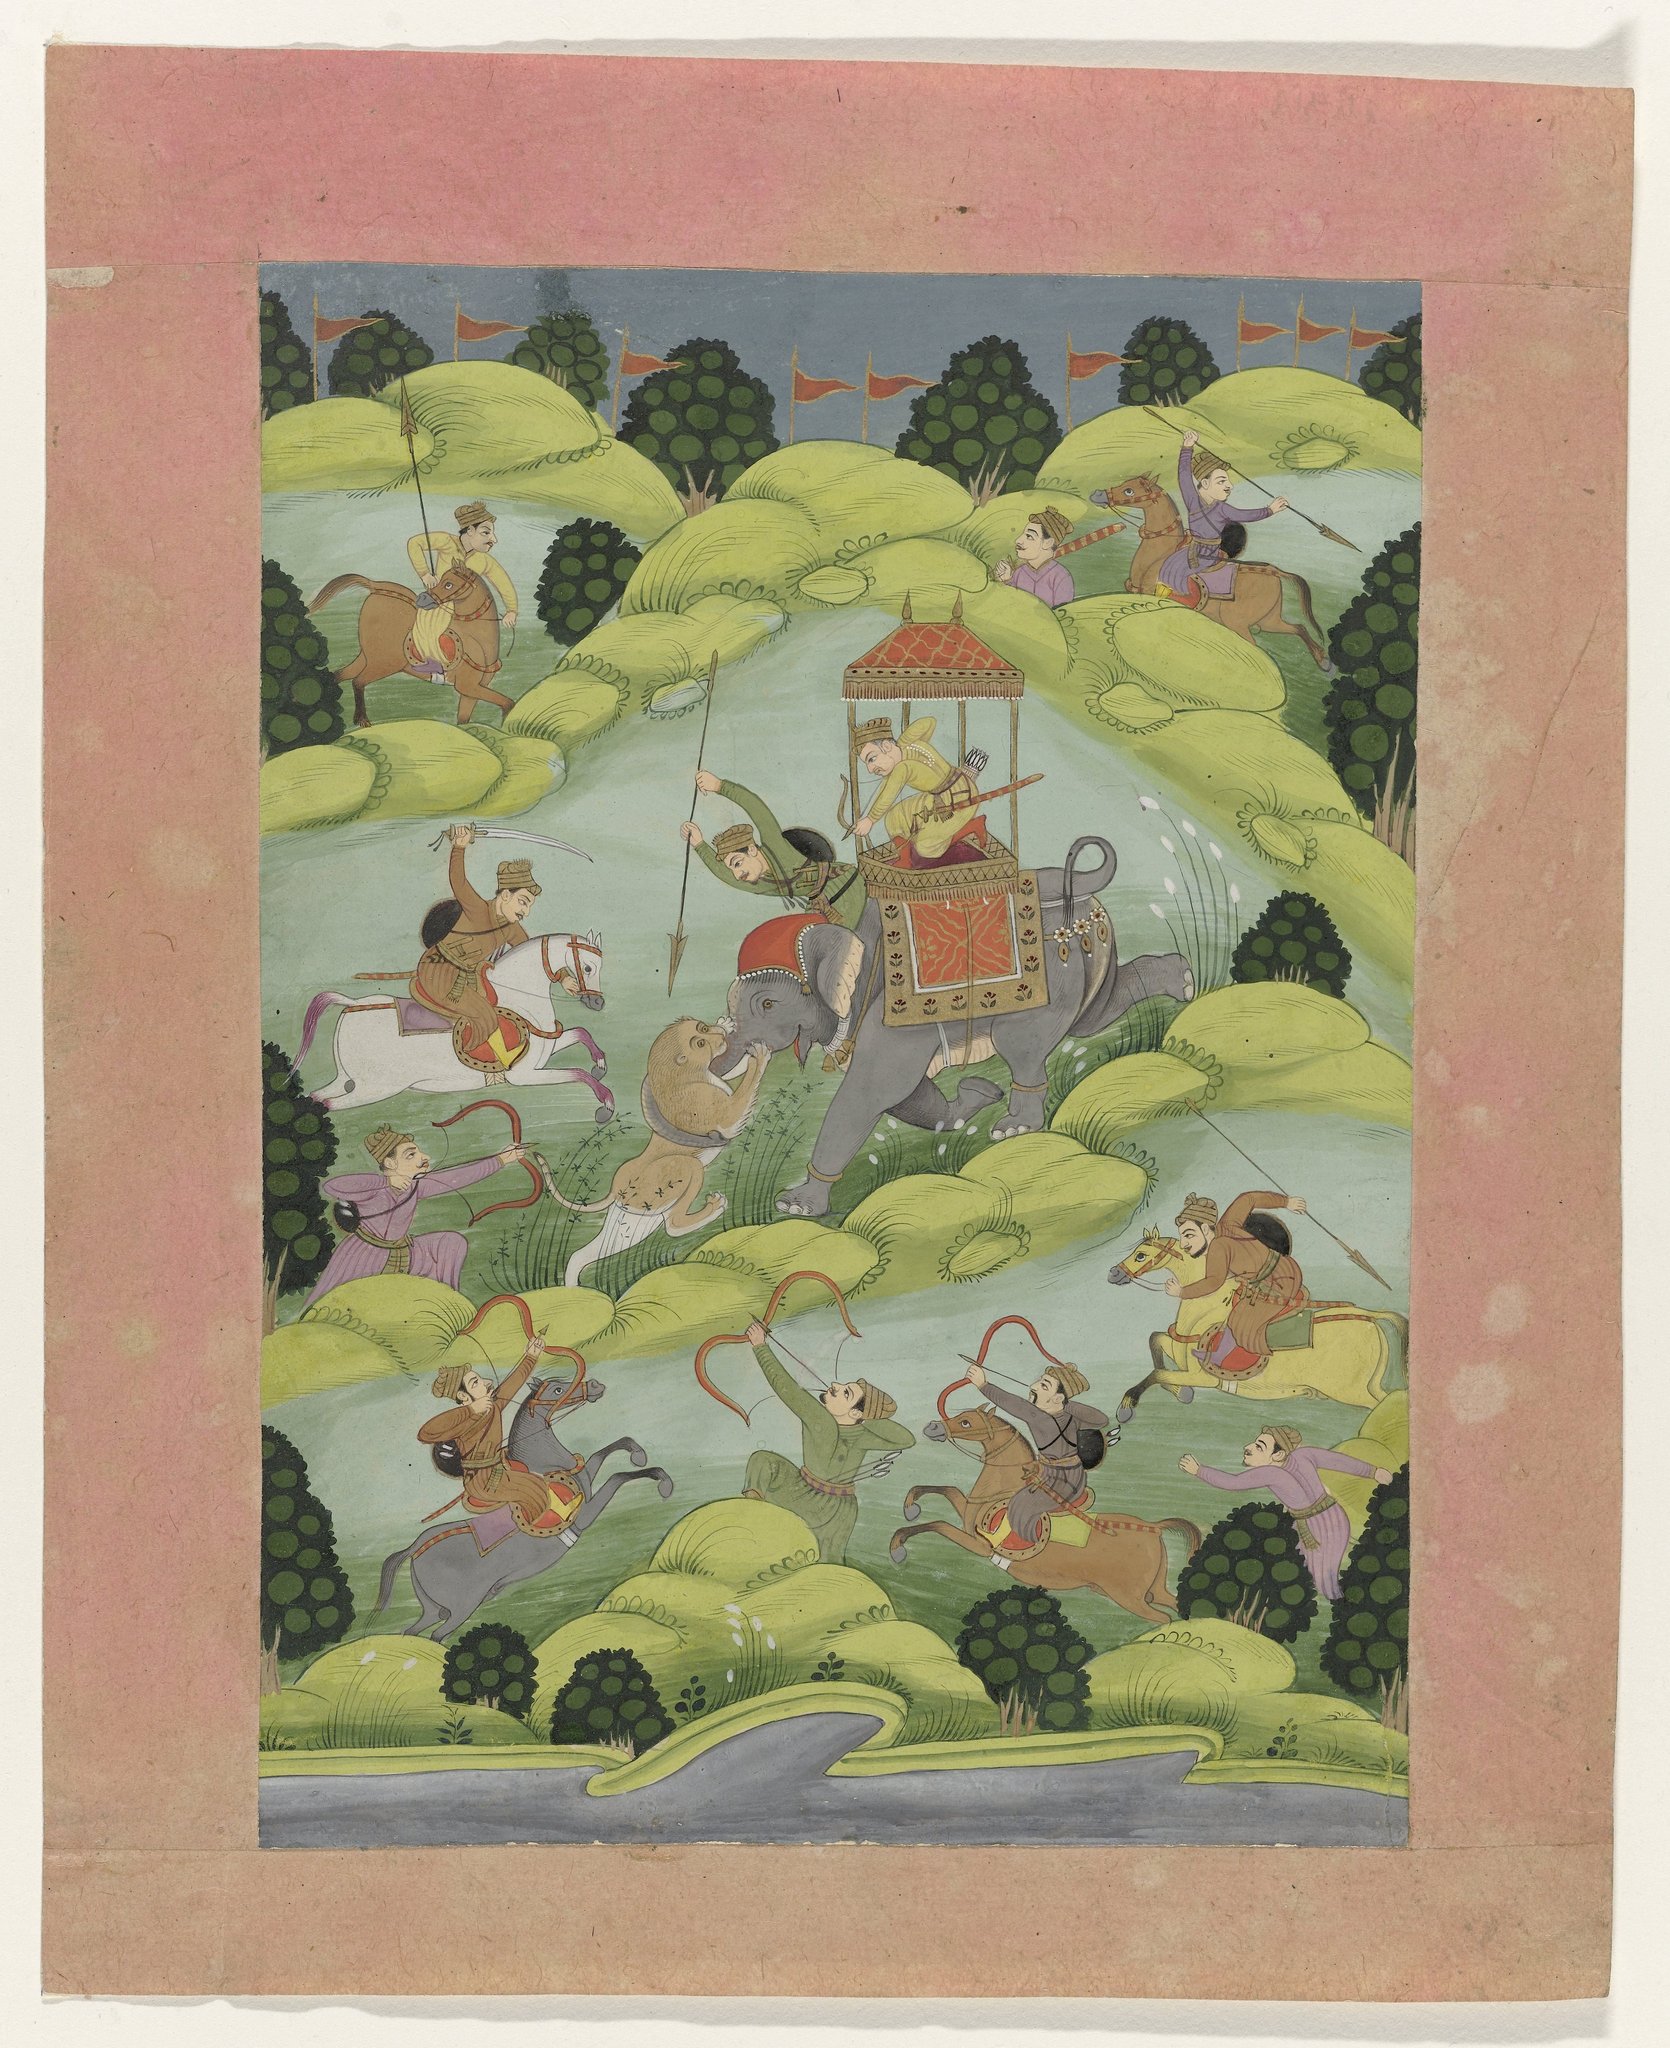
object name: drawing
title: Rajput prins op leeuwenjacht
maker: Anonymous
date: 1675-1699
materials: paint, gouache, paper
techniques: brush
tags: hunt ~ predatory animals (fox, lion)